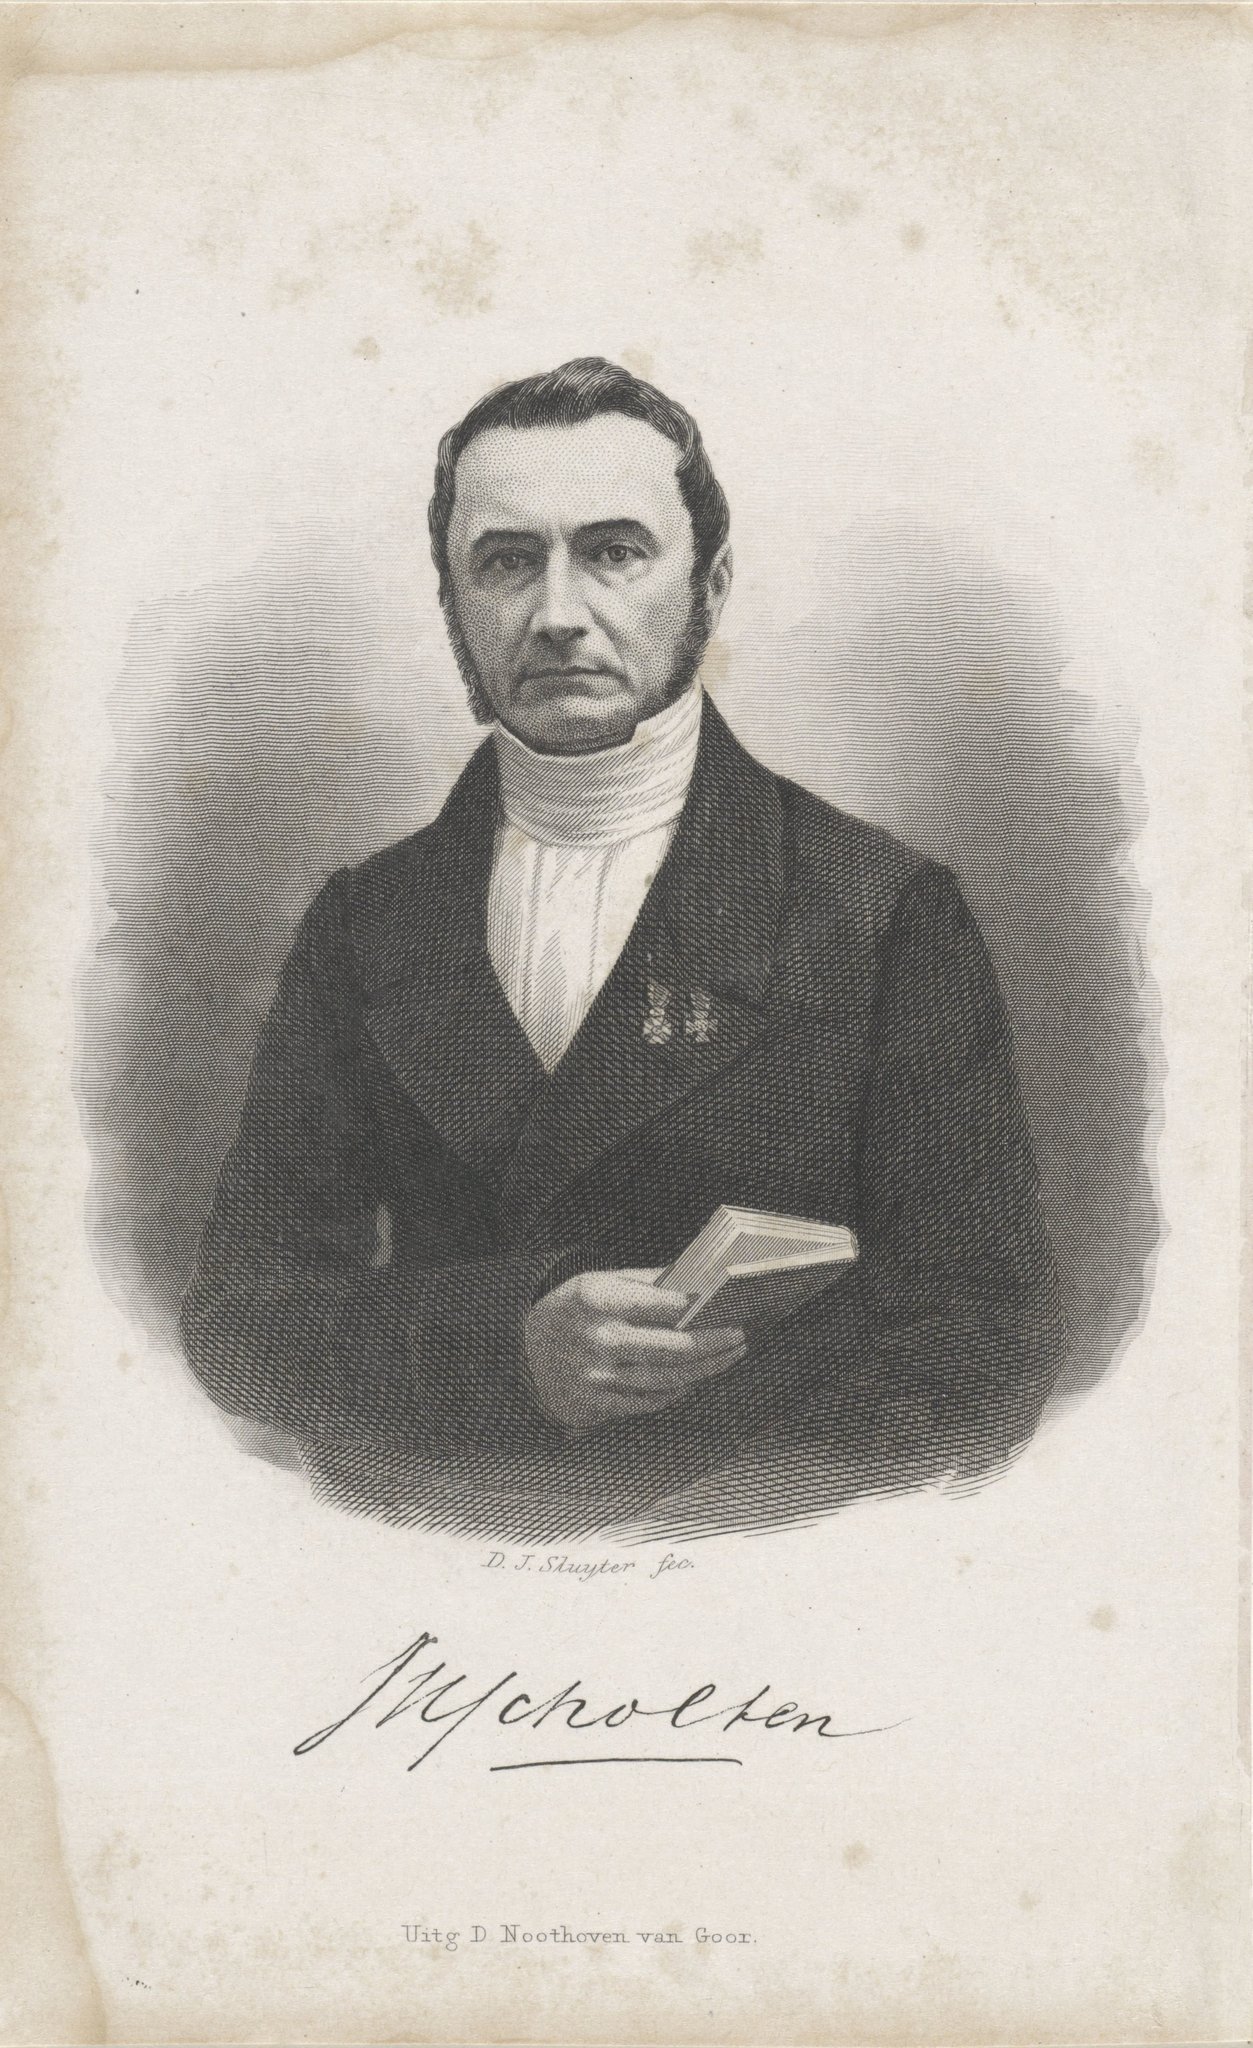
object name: print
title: Portret van Johannes Henricus Scholten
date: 1850-1886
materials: paper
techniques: etching, engraving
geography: amsterdam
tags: vleuten, leiden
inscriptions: collector's mark: Lugt 2228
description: Portret van de hoogleraar theologie Johannes Henricus Scholten. Hij houdt een boek in de hand. Op zijn rever twee onderscheidingen. Onder het portret zijn handtekening.